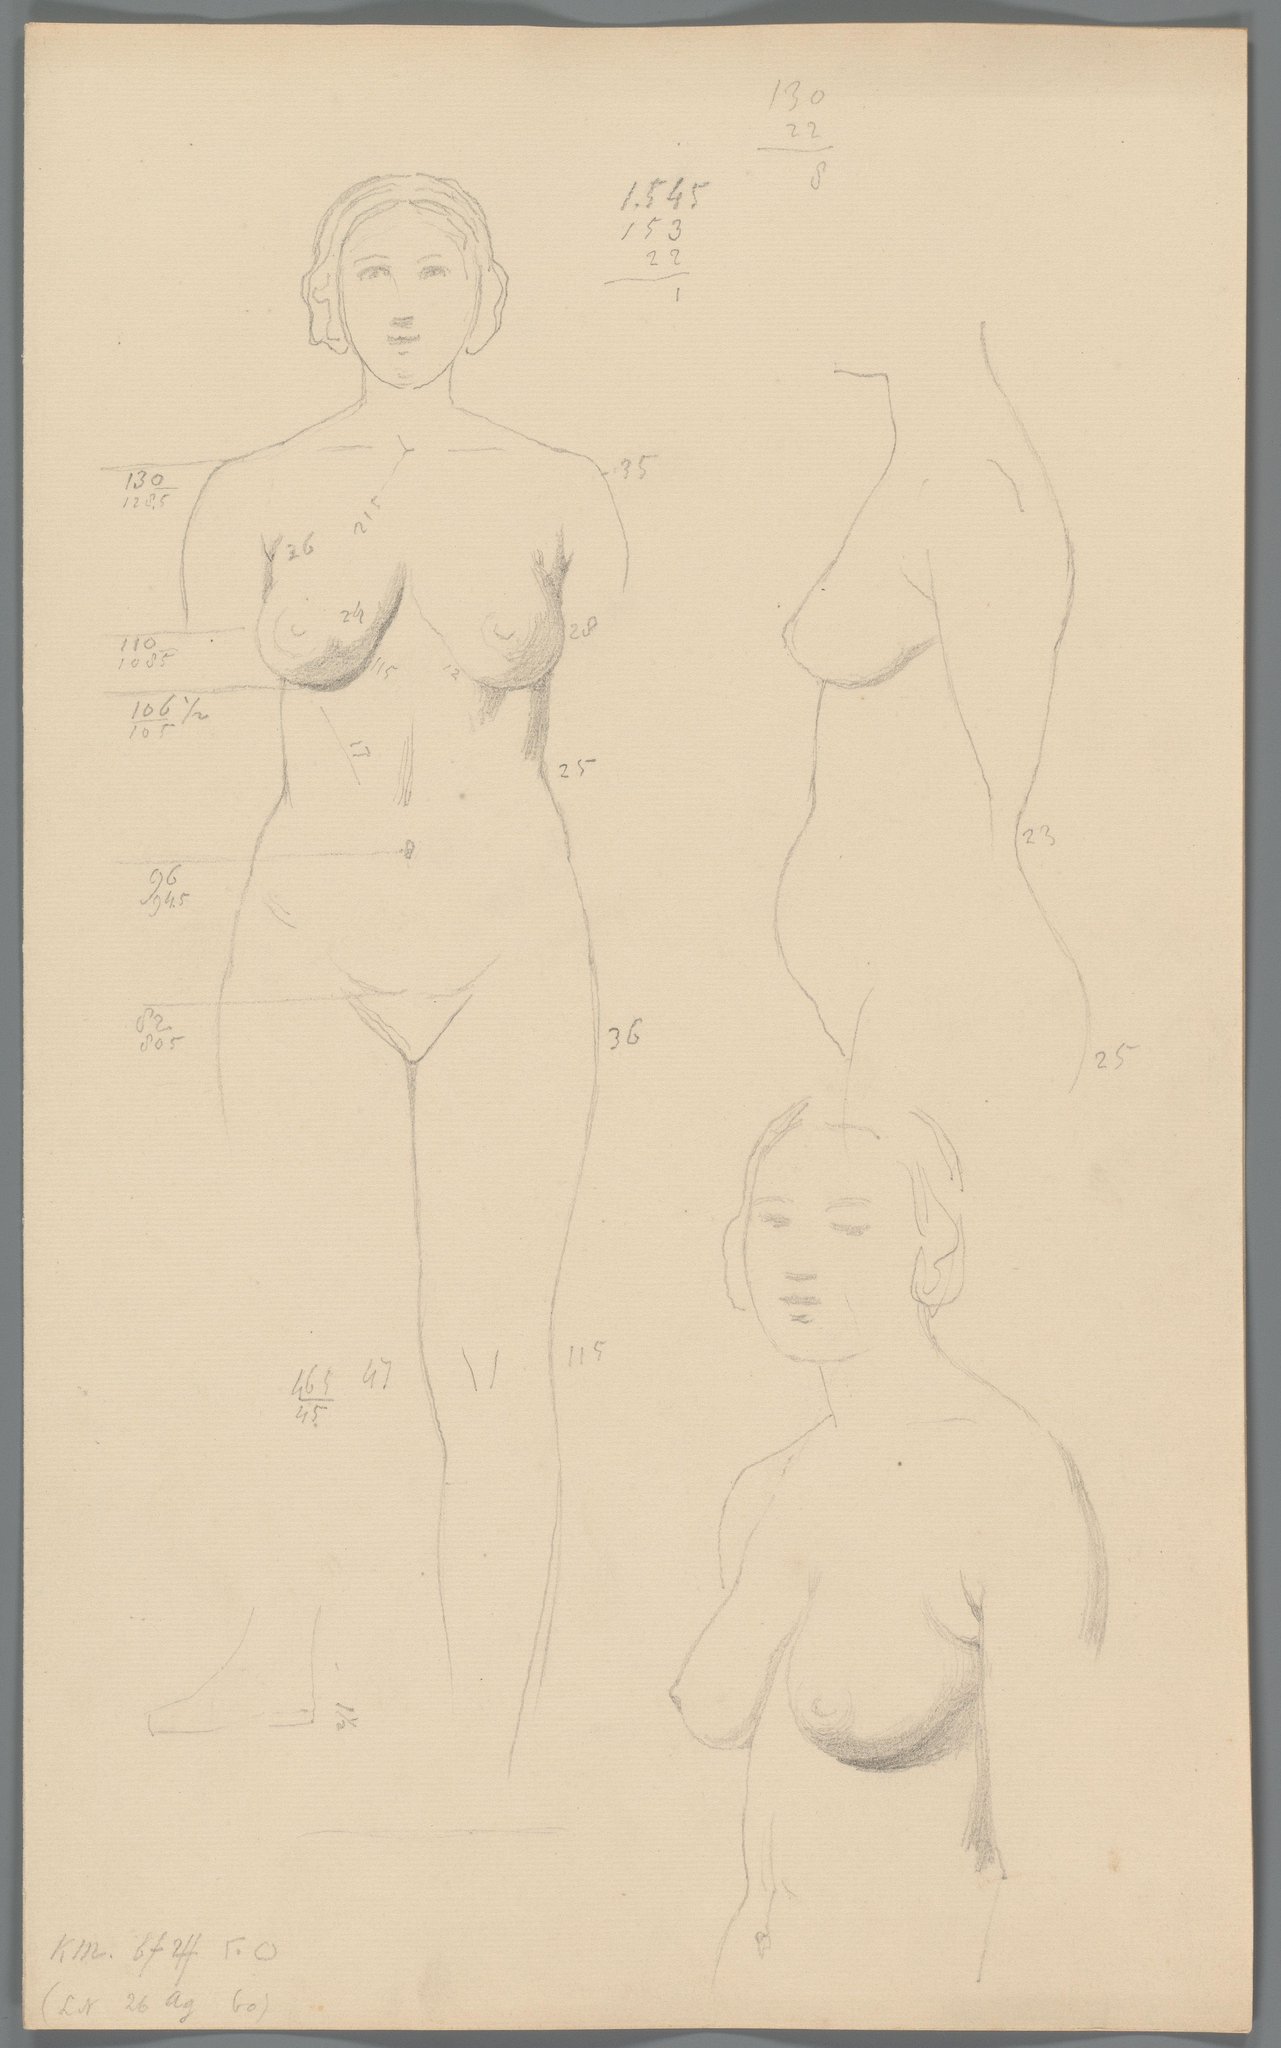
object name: drawing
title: Proportiestudies van een vrouw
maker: jacobus everhardus josephus van den berg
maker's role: draughtsman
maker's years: 1802-1861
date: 1812-1861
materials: paper, pencil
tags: standing figure (canon, proportions) - aa - female human figure, the (nude) human figure; 'corpo humano' (ripa) - aa - female human figure